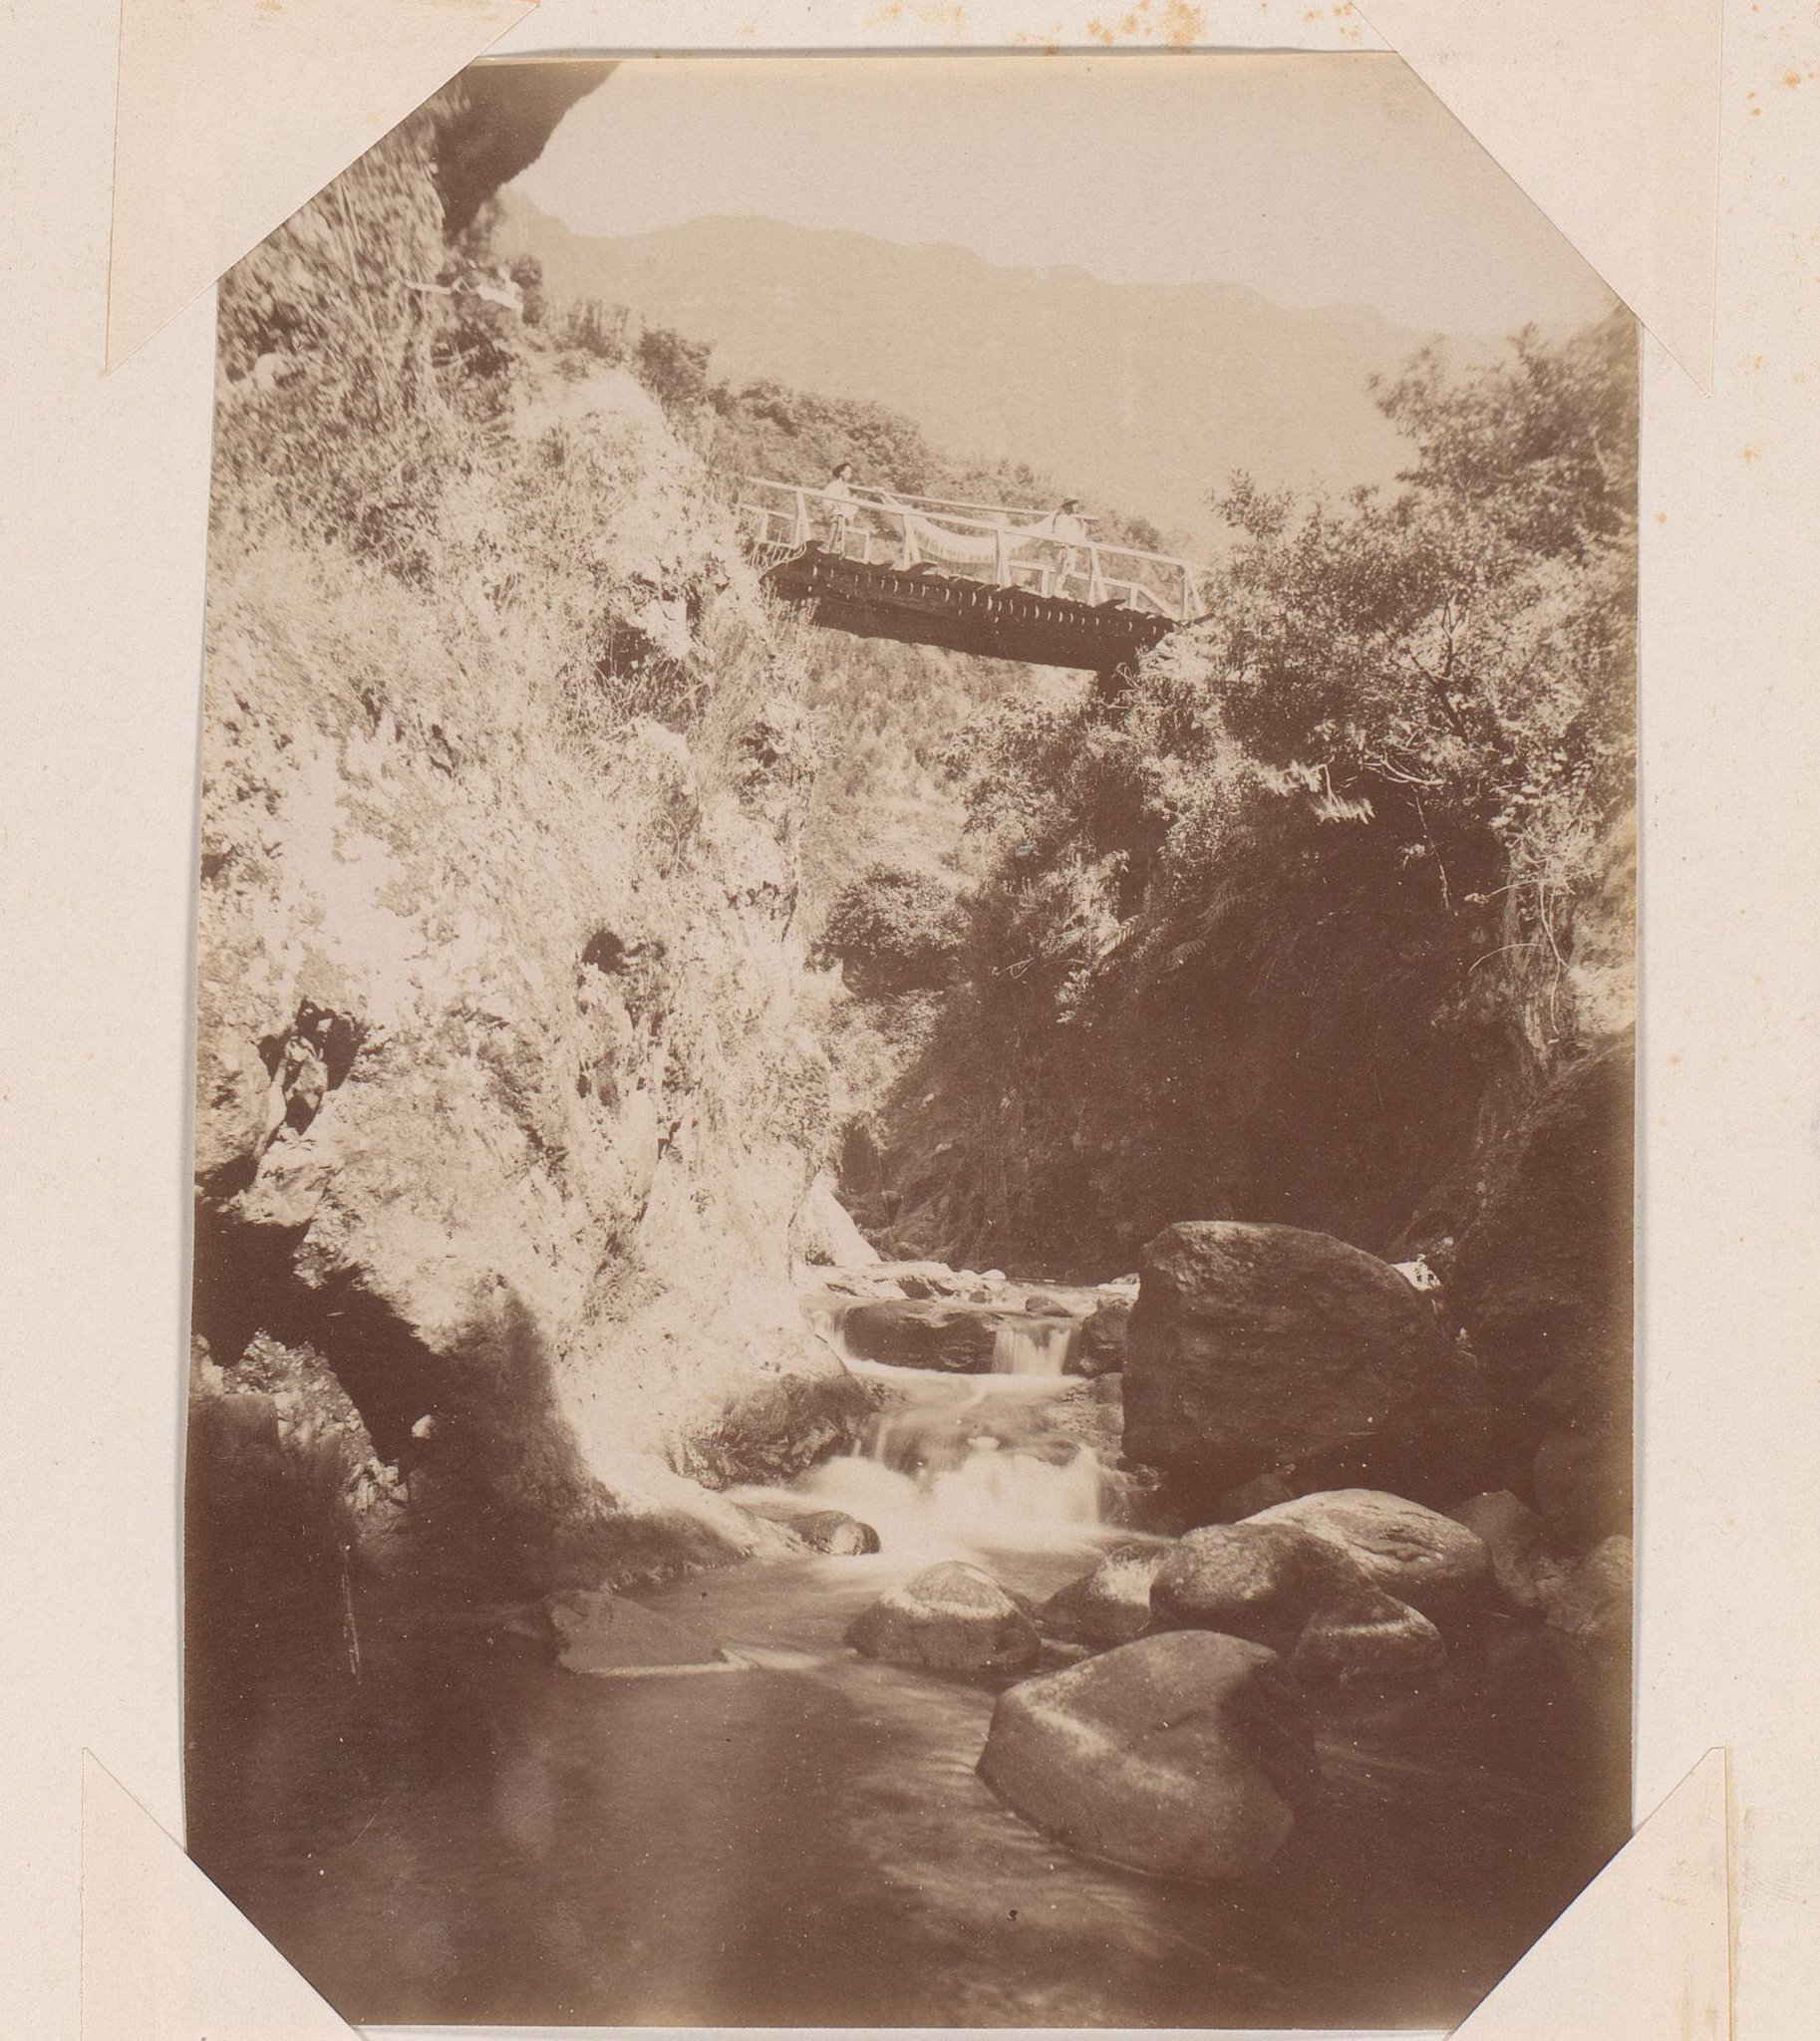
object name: photograph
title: Madeira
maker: Anonymous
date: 1885-1910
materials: paper, photographic support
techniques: albumen print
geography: madeira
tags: (carrying a person on a) litter, stretcher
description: Onderdeel van Album met 191 foto's van een reis naar en door Zuid-Afrika.